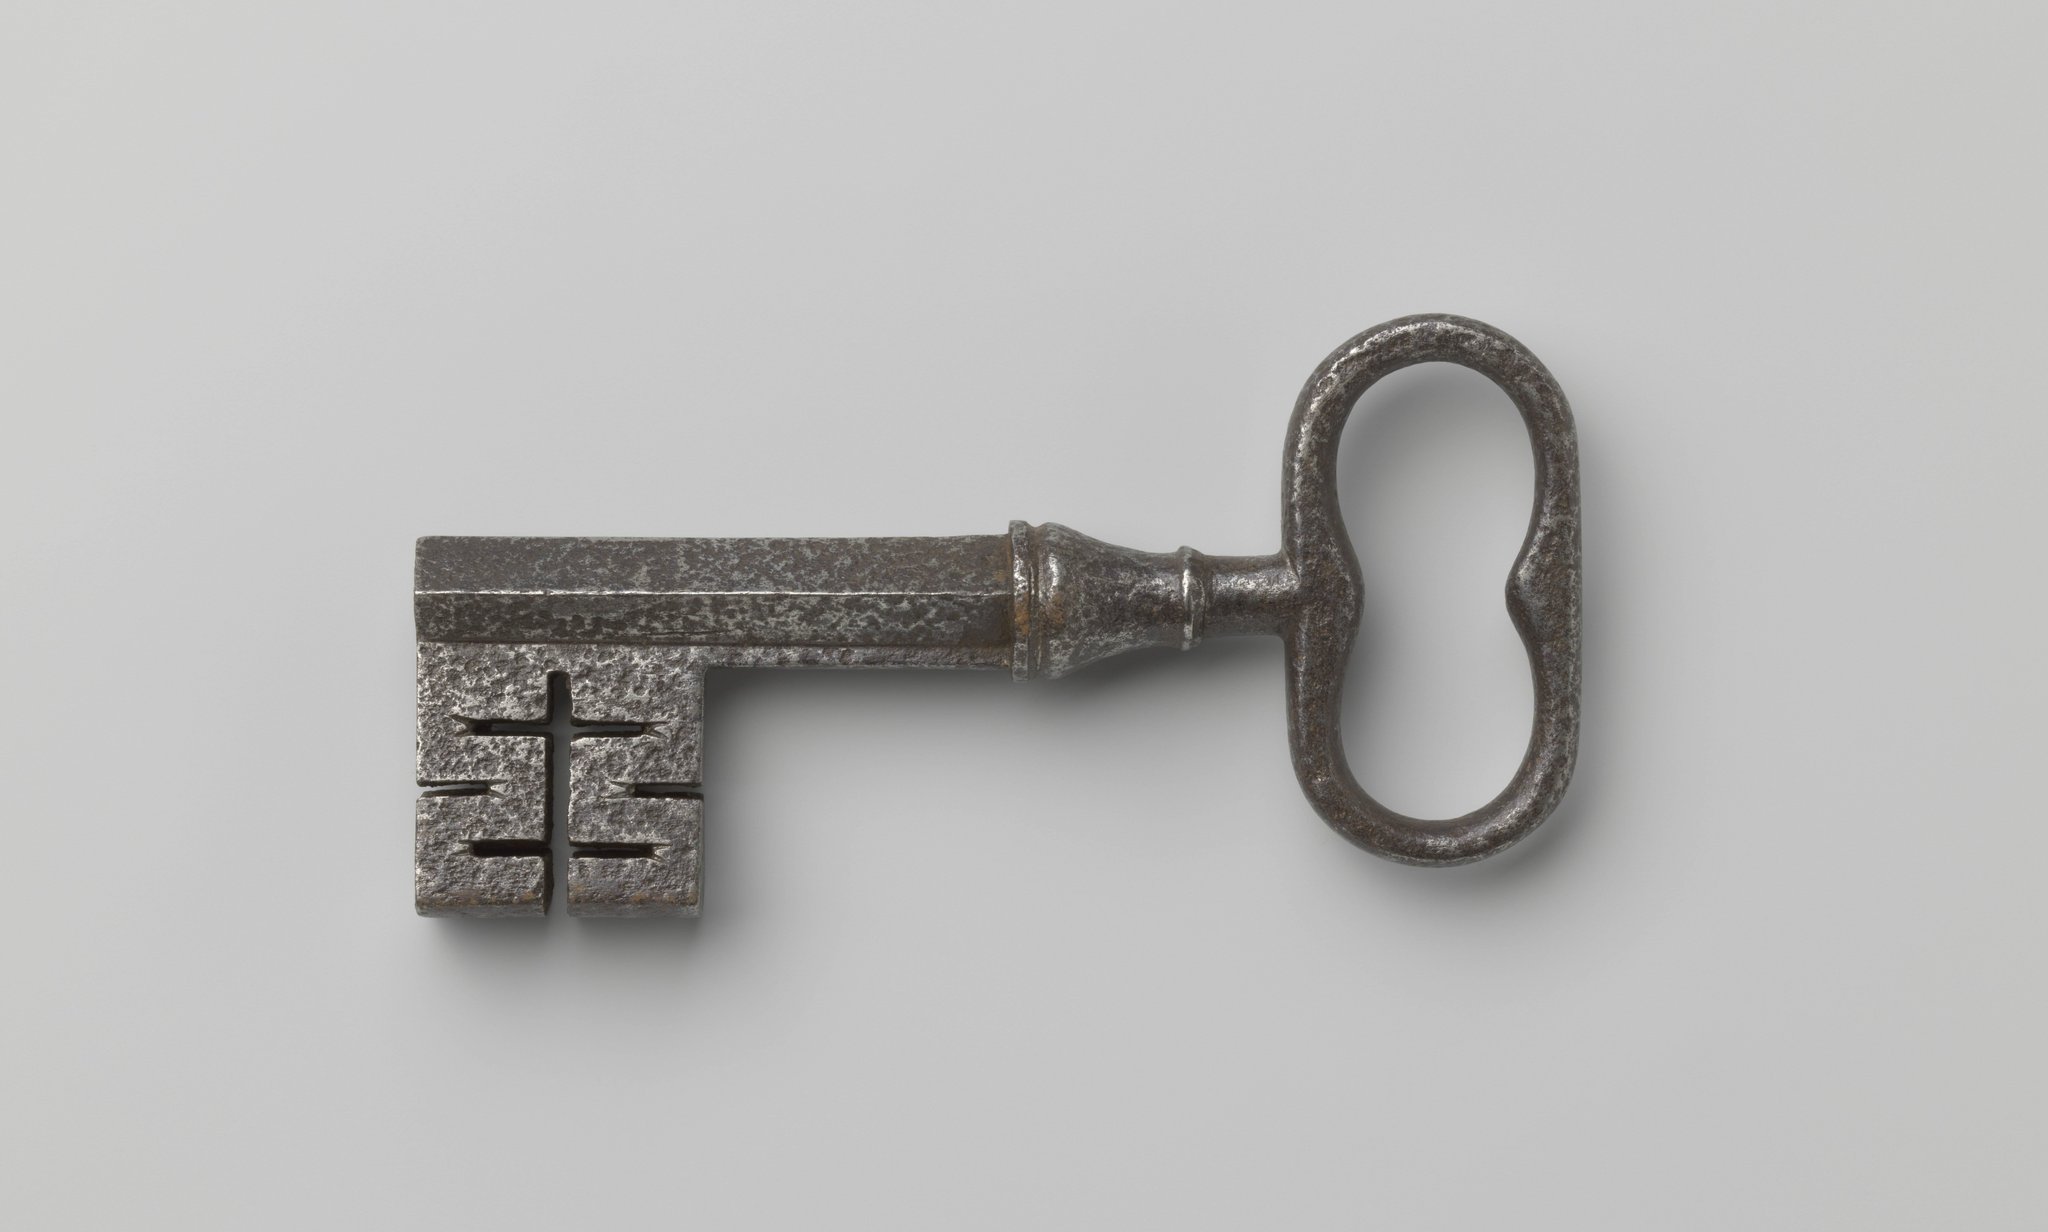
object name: key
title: Sleutel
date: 1800-1900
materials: iron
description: Sleutel met vierhoekige schacht onder de geprofileerde sleutelborst. Baard van boven wigvormig.